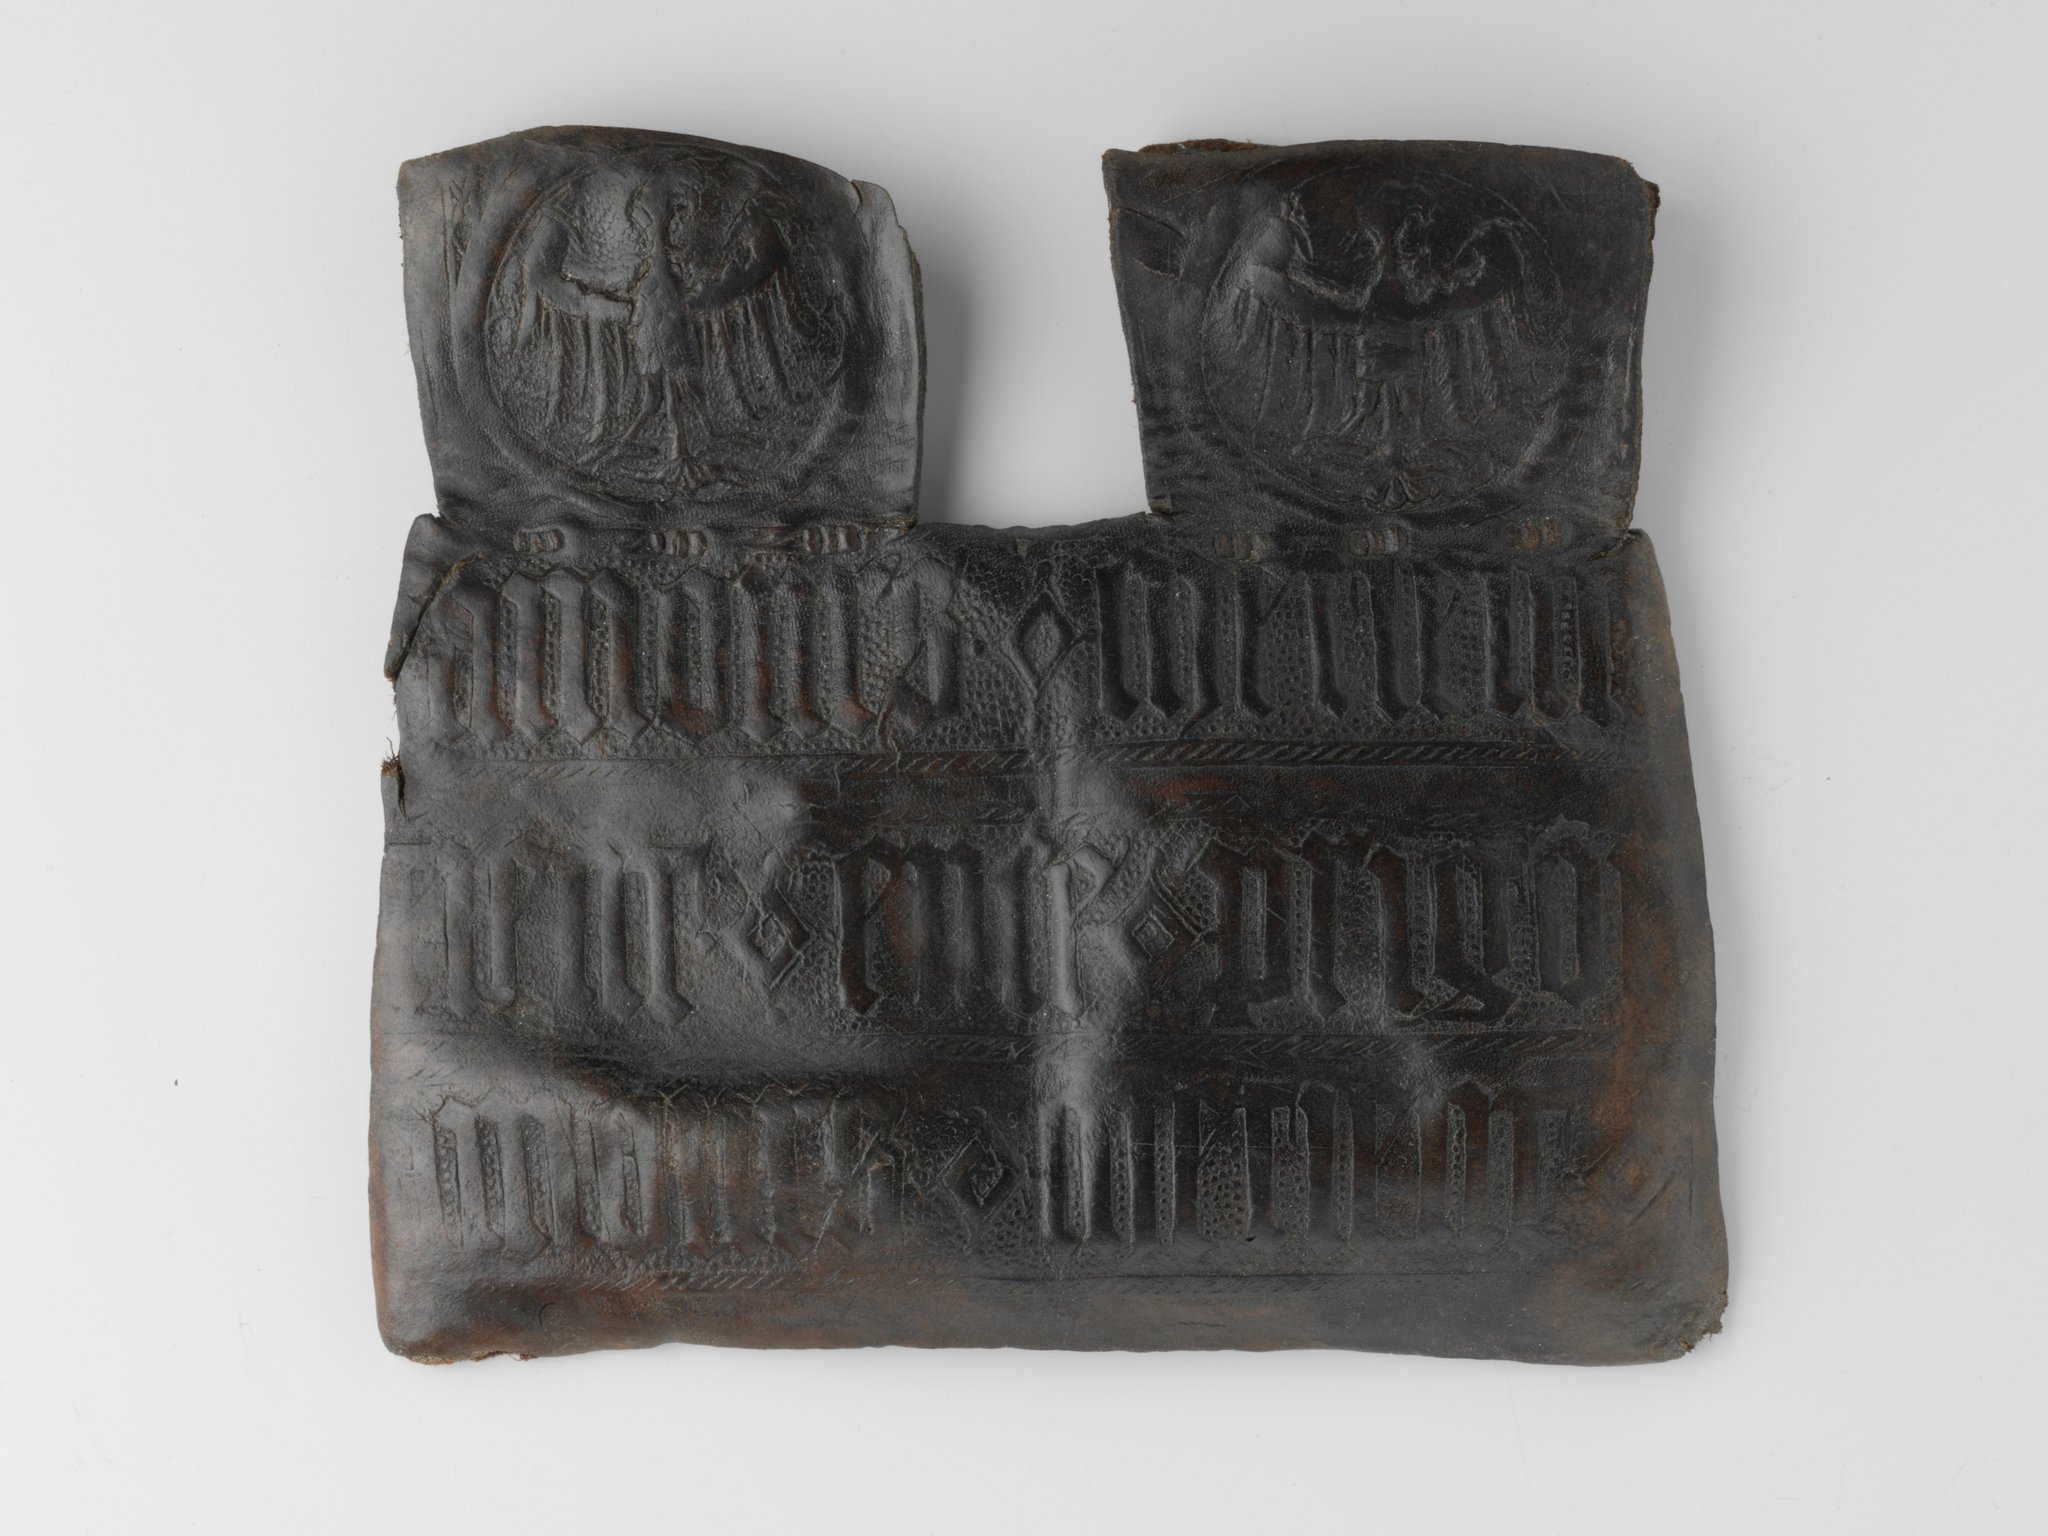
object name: purse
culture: french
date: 1400-1409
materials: leather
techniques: tooling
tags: eagles